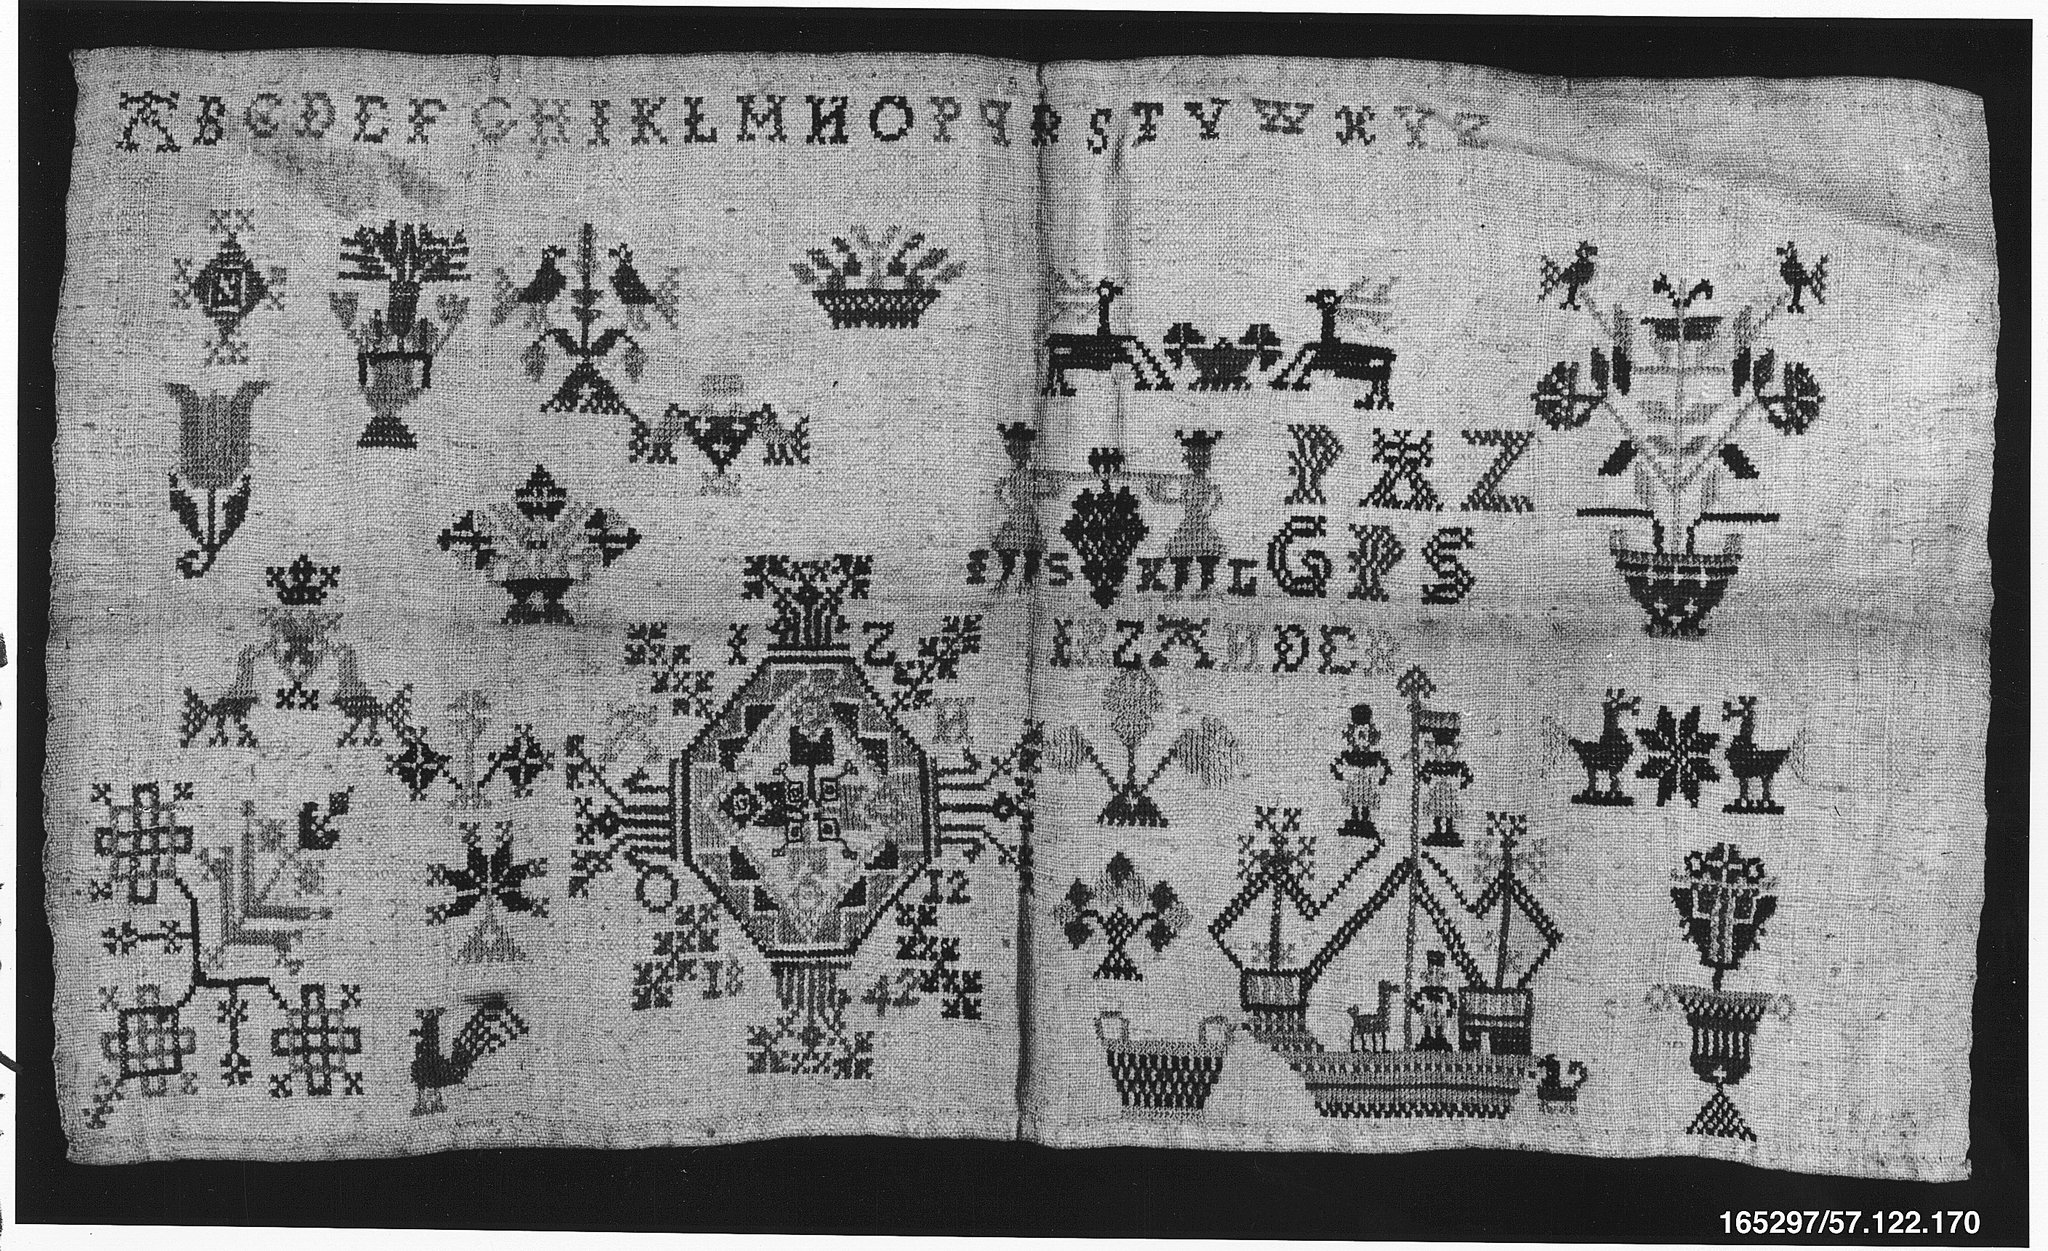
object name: sampler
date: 1842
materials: cotton, linen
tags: birds,flowers,leaves